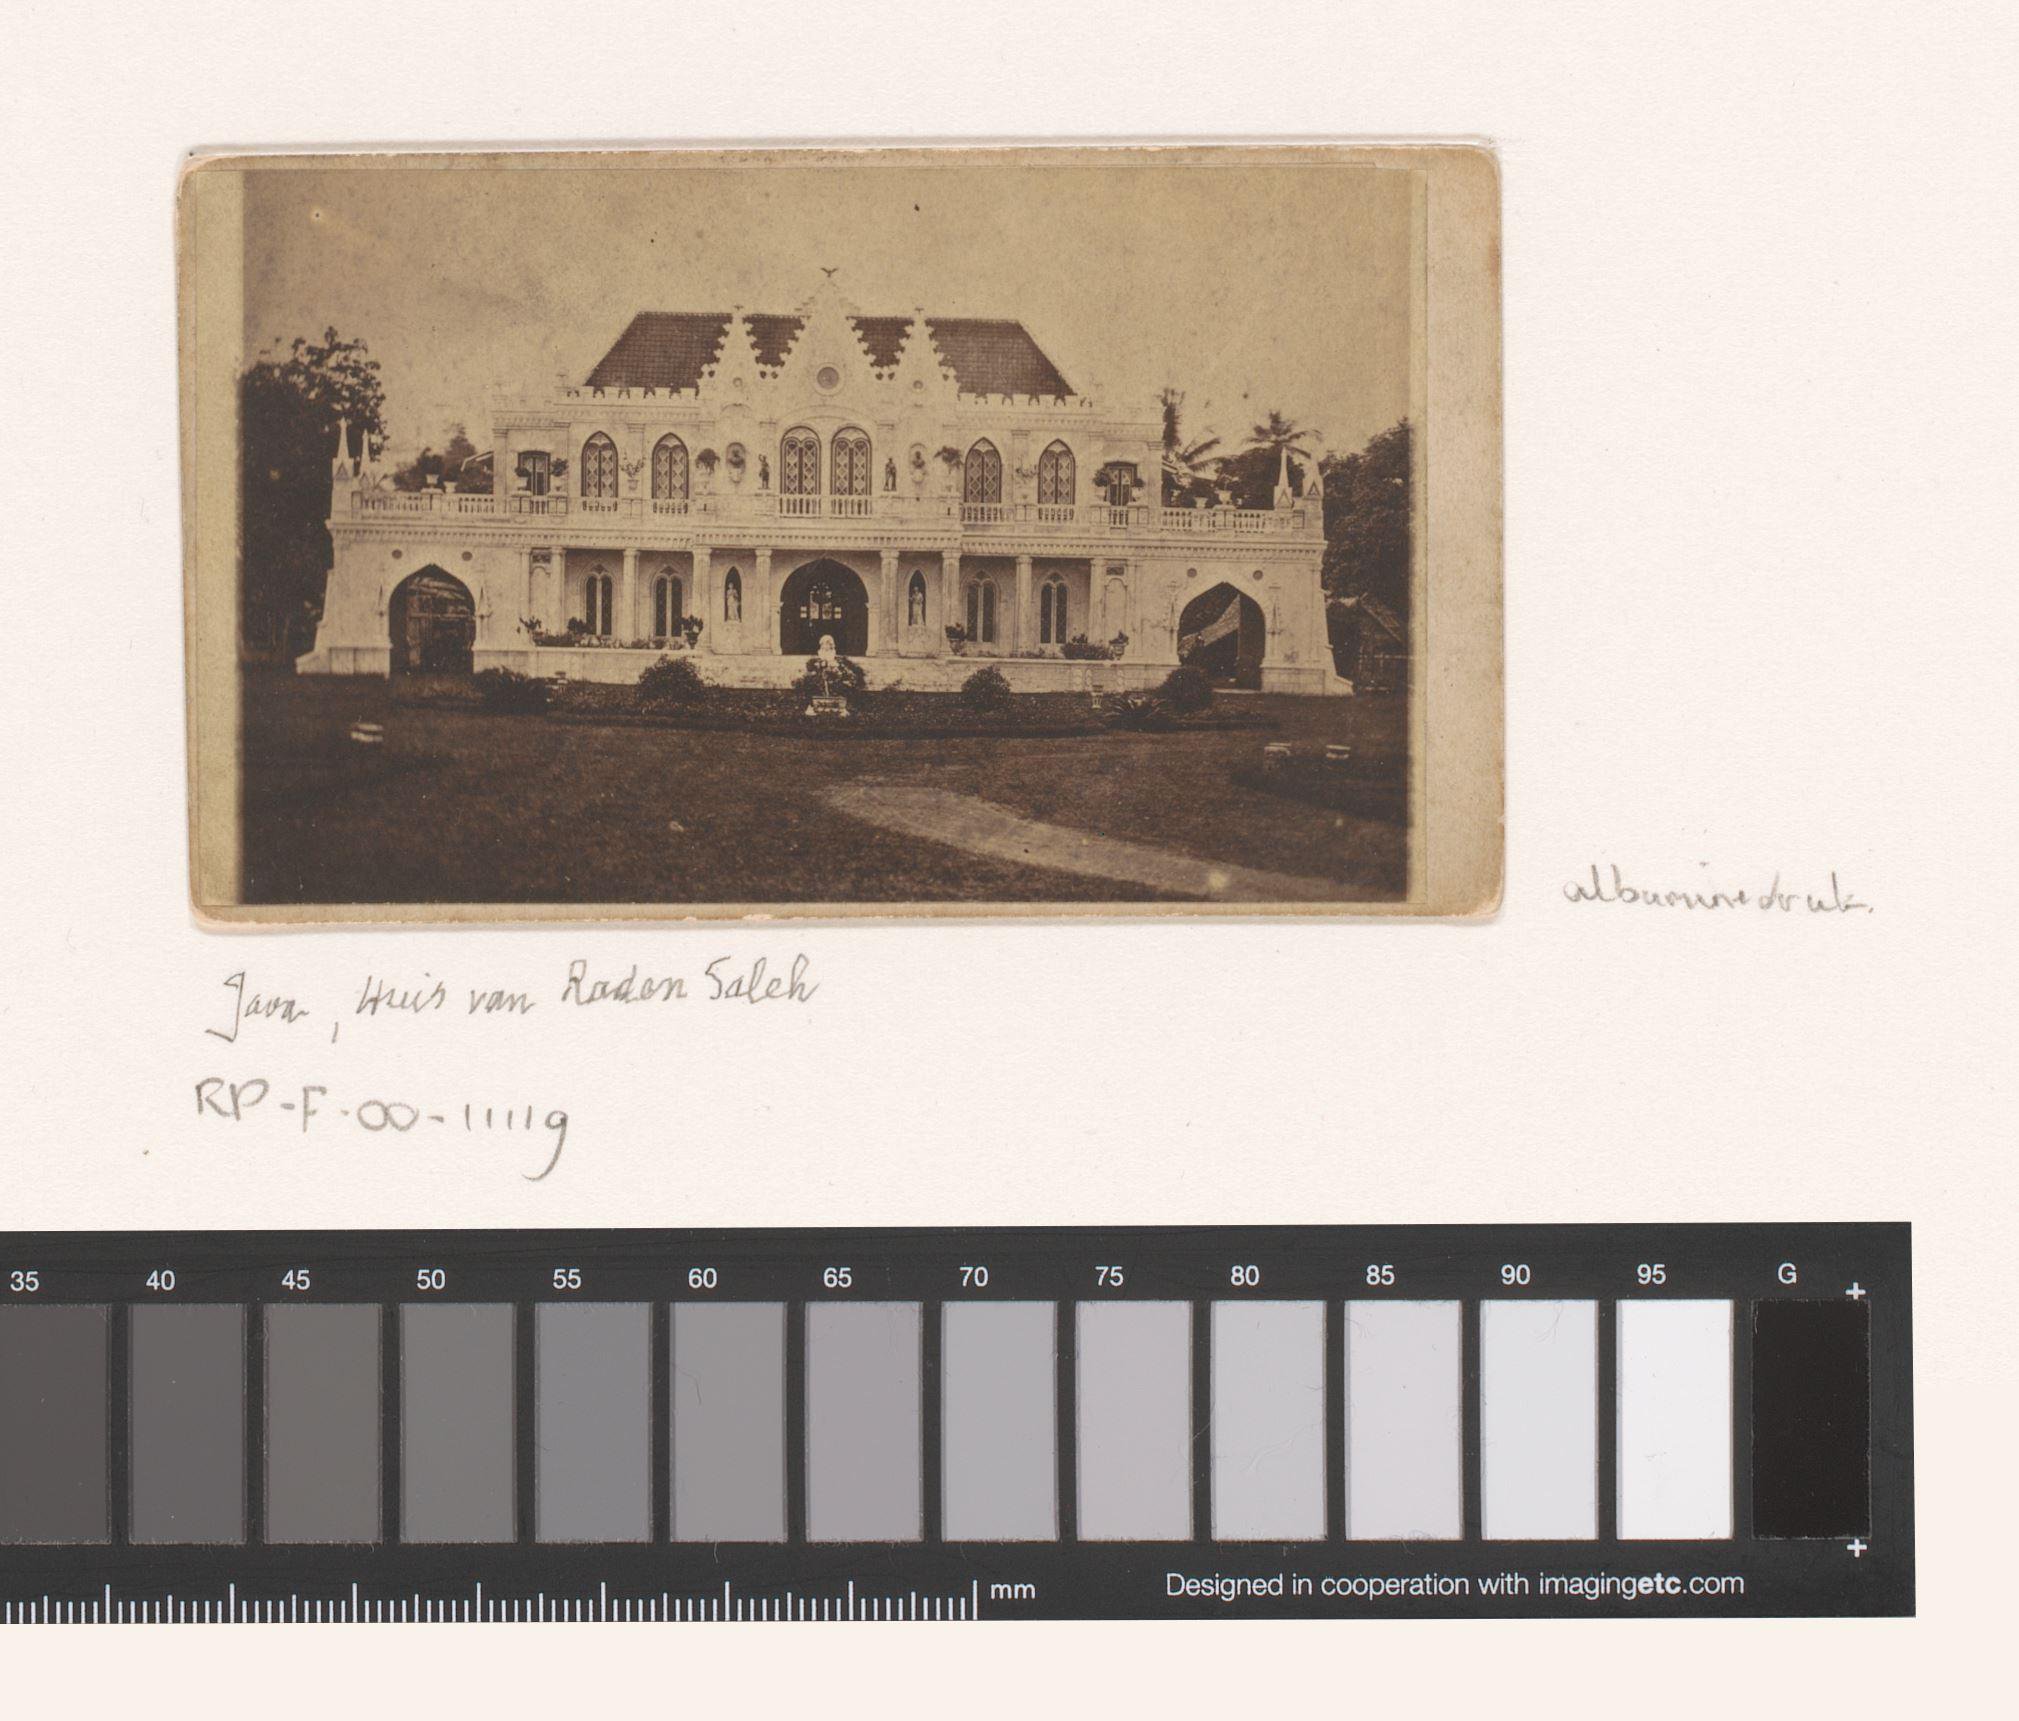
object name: photograph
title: Gezicht op het huis van Raden Saleh op Java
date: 1855-1900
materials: cardboard, photographic support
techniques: albumen print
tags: painter, draughtsman, raden sarief bastaman saleh, country-house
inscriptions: annotation: ‘Huis van Raden Saleh’